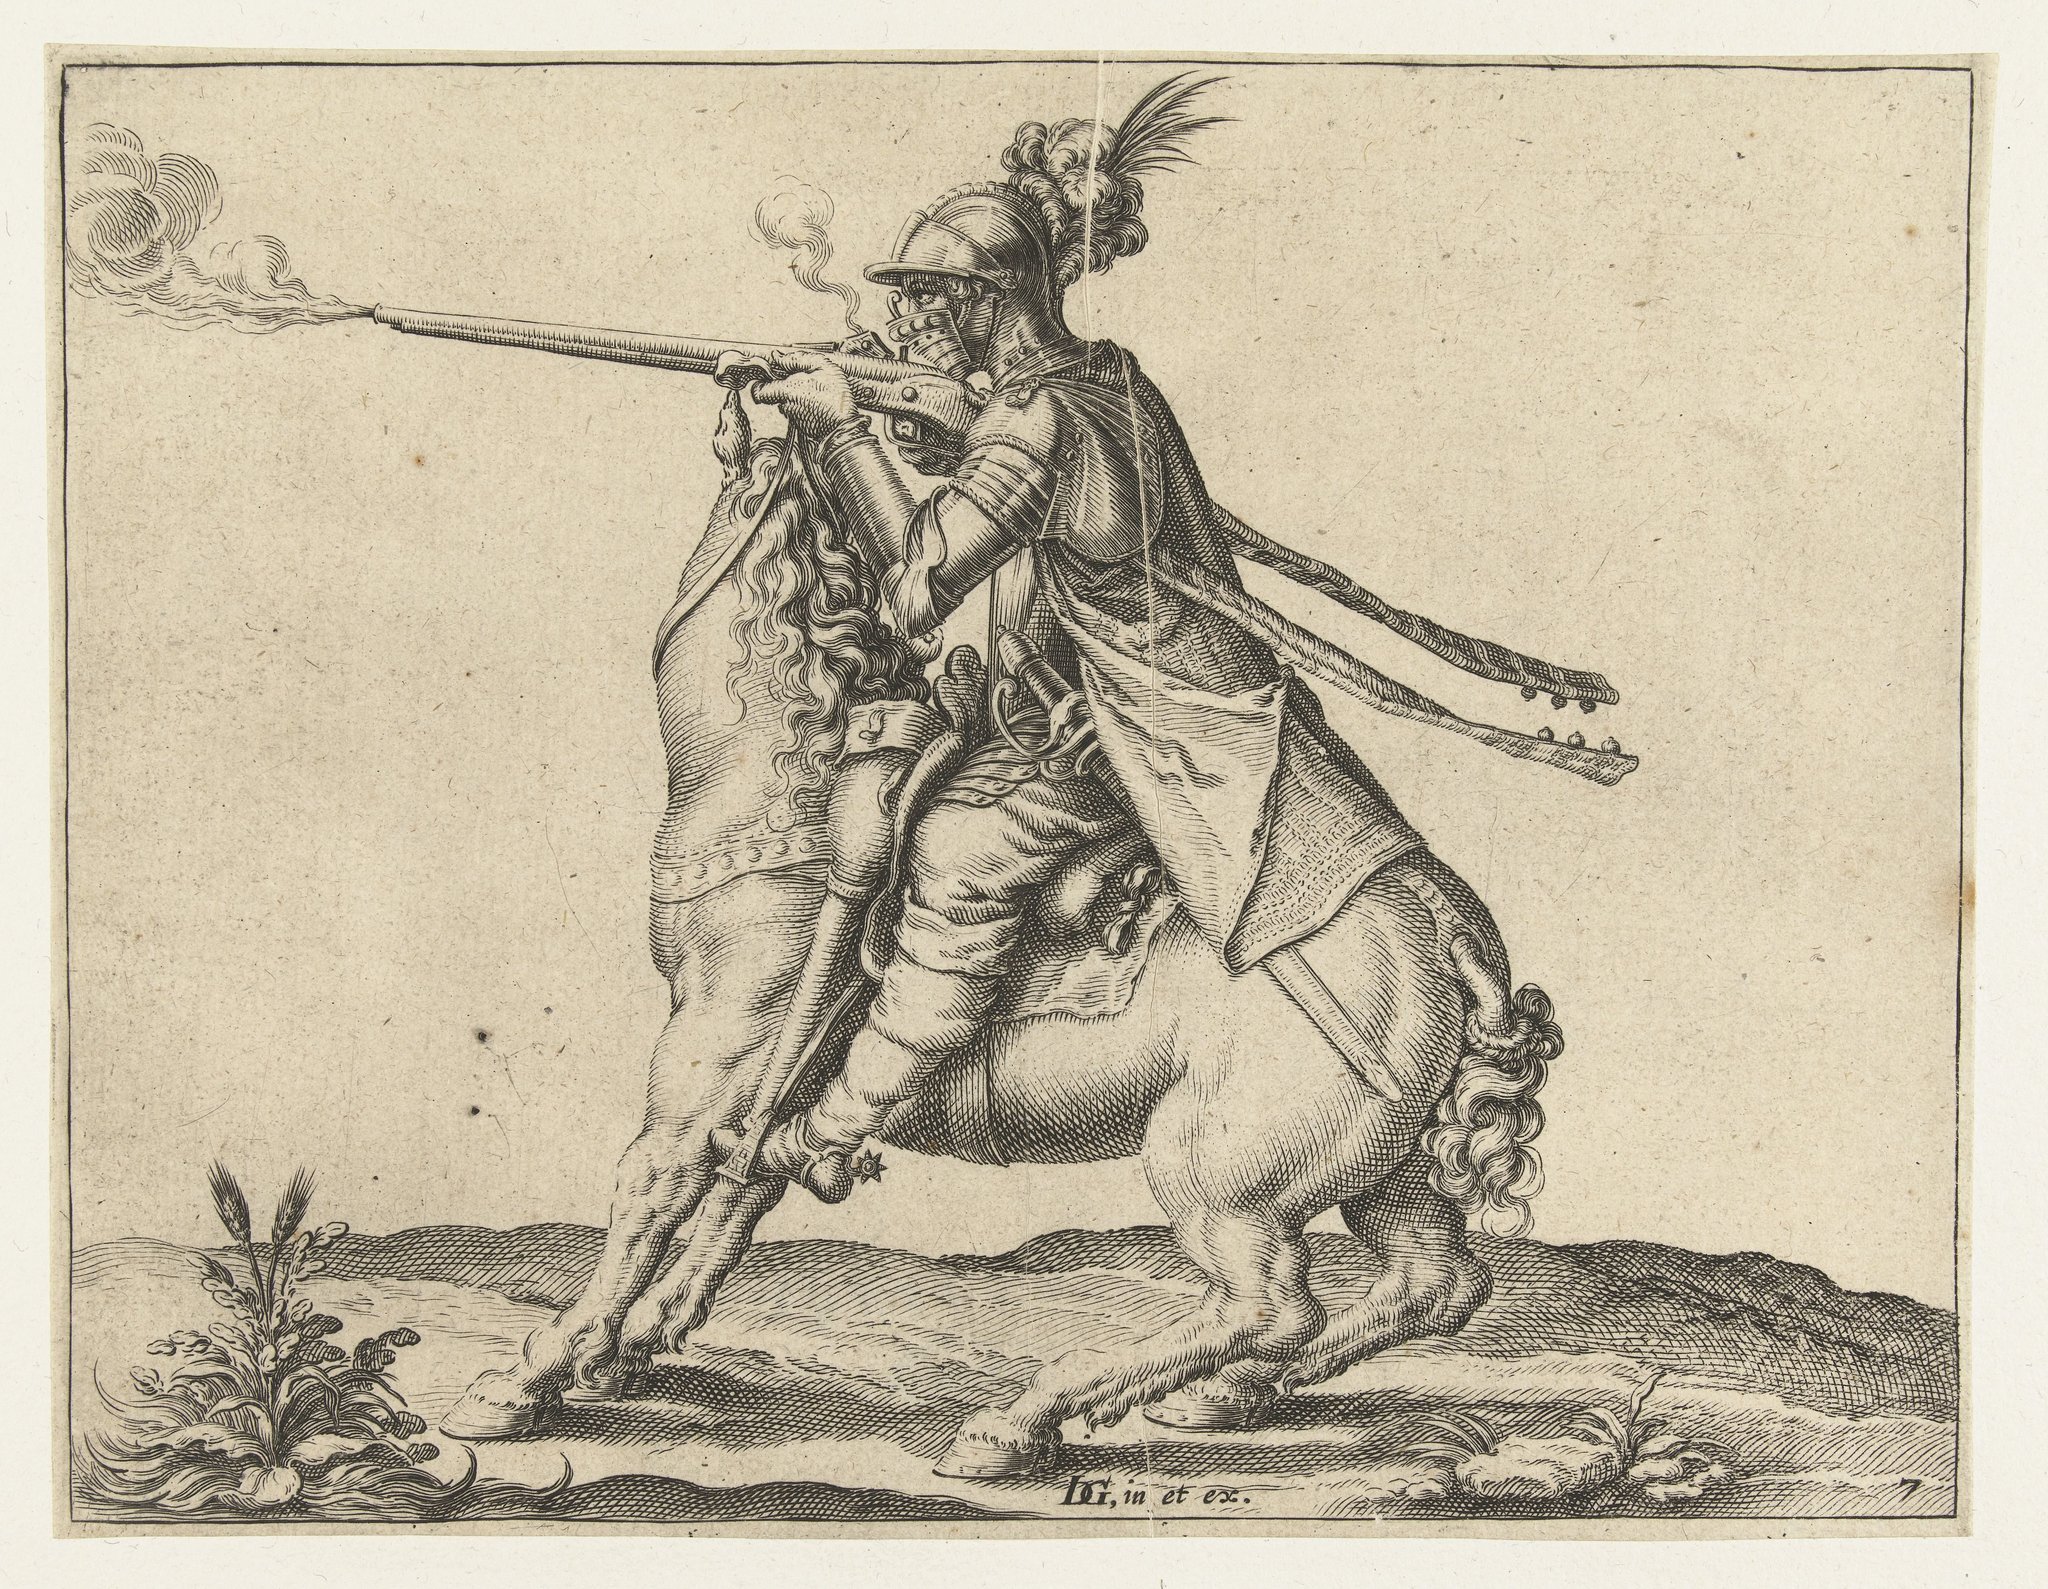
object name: print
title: De ruiterschool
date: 1599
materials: paper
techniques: engraving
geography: netherlands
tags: warfare; military affairs (+ cavalry, horsemen), firearms: rifle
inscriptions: collector's mark: Lugt 2228a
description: Een geharnaste man te paard, naar links een schot vurend met een harquebus (licht type geweer). Deze prent is onderdeel van een serie van 22 genummerde prenten: een titelprent, 20 prenten waarop één of enkele verschillende typen (meest geharnaste) ruiters zijn weergegeven, en een prent met een ruitergevecht.